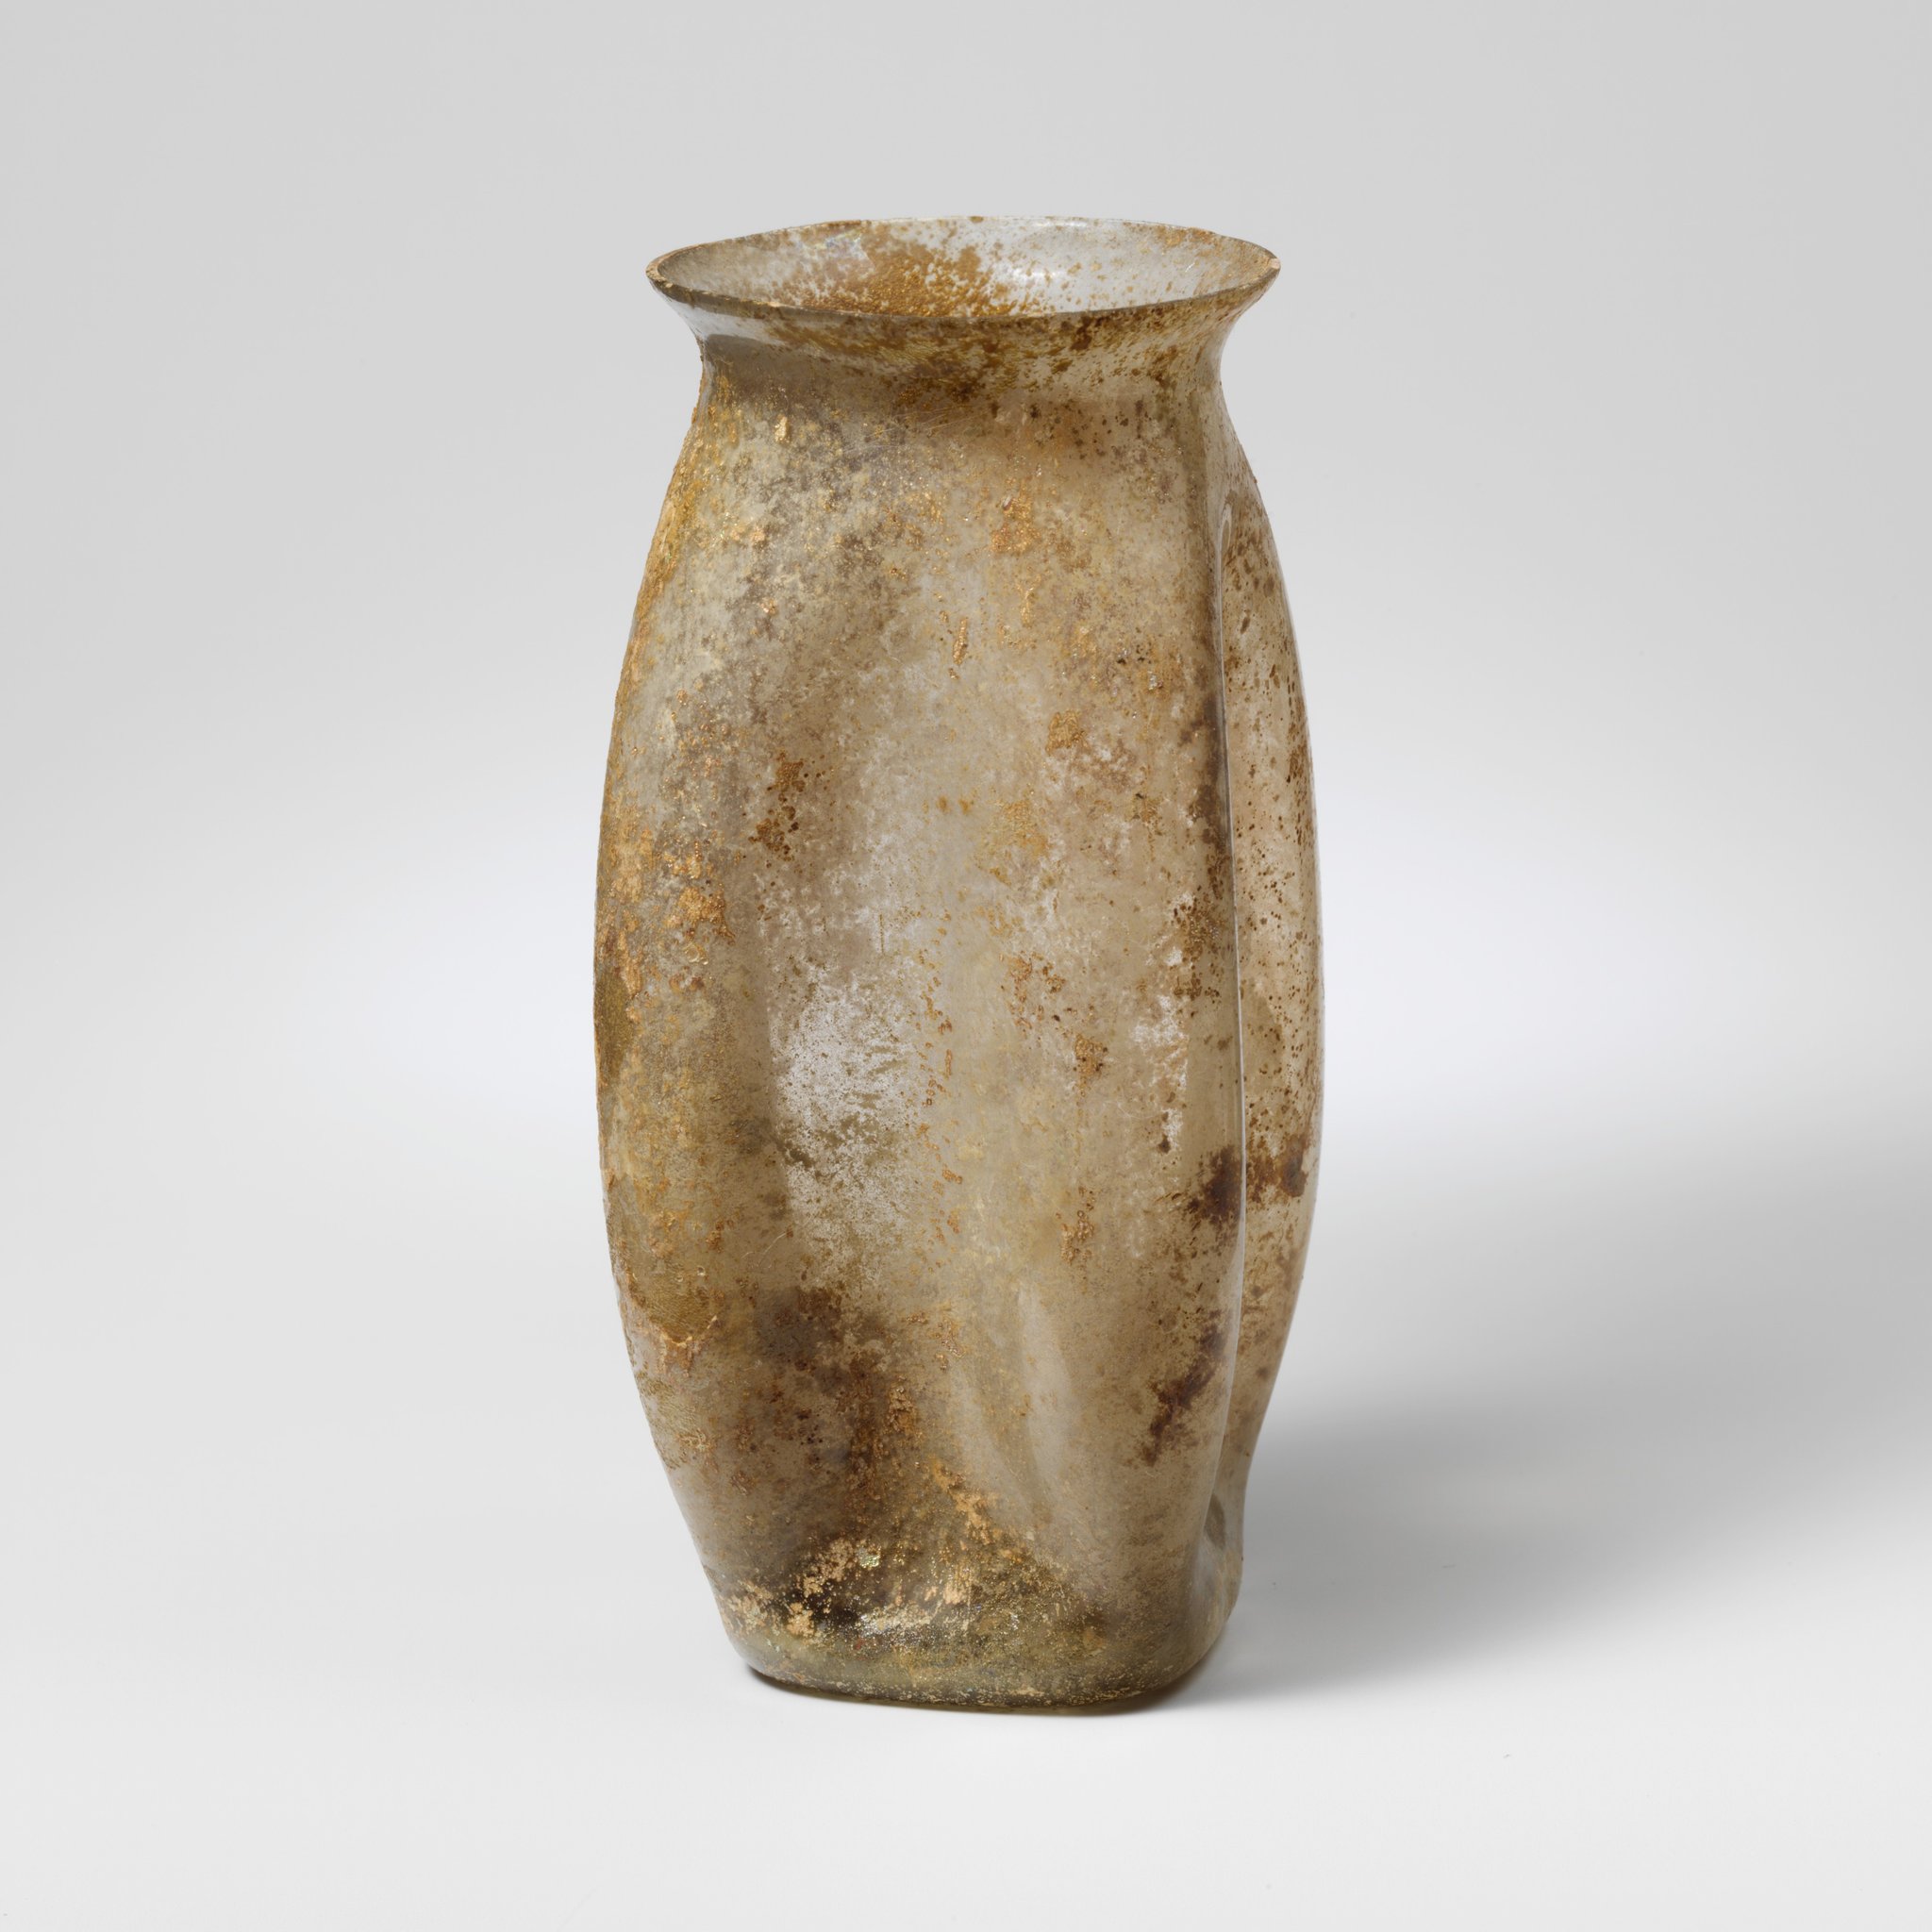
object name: beaker, indented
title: Glass beaker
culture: roman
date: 101-300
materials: glass